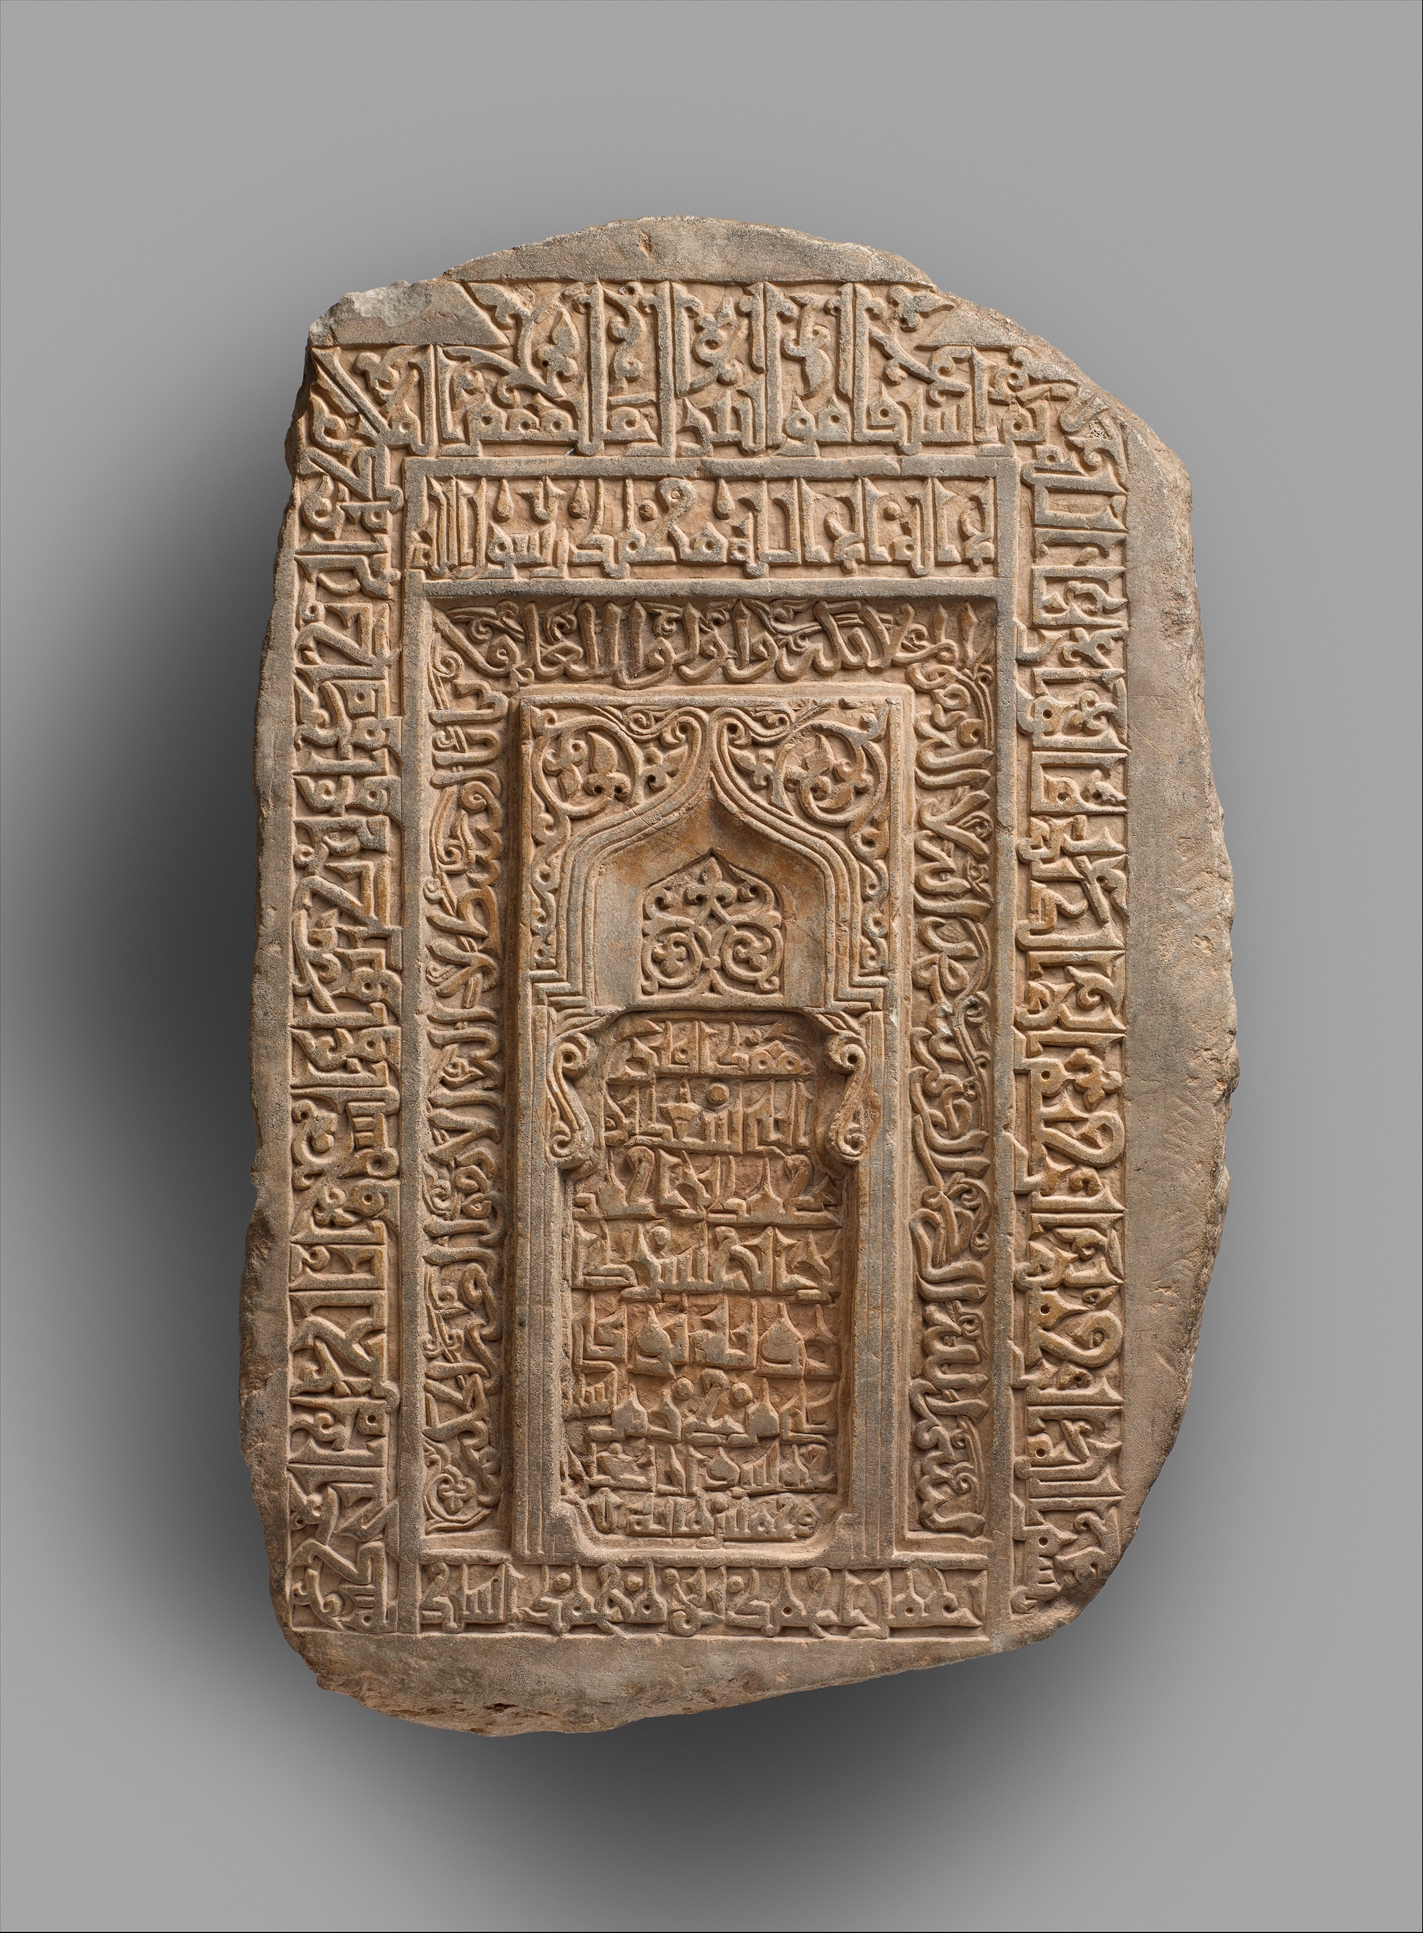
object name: tombstone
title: Tombstone of Abu Sa'd ibn Muhammad ibn Ahmad al-Hasan Karwaih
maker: ahmad ibn muhammad astak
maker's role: maker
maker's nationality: iranian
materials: marble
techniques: carving, painting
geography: iran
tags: mihrabs,arabic